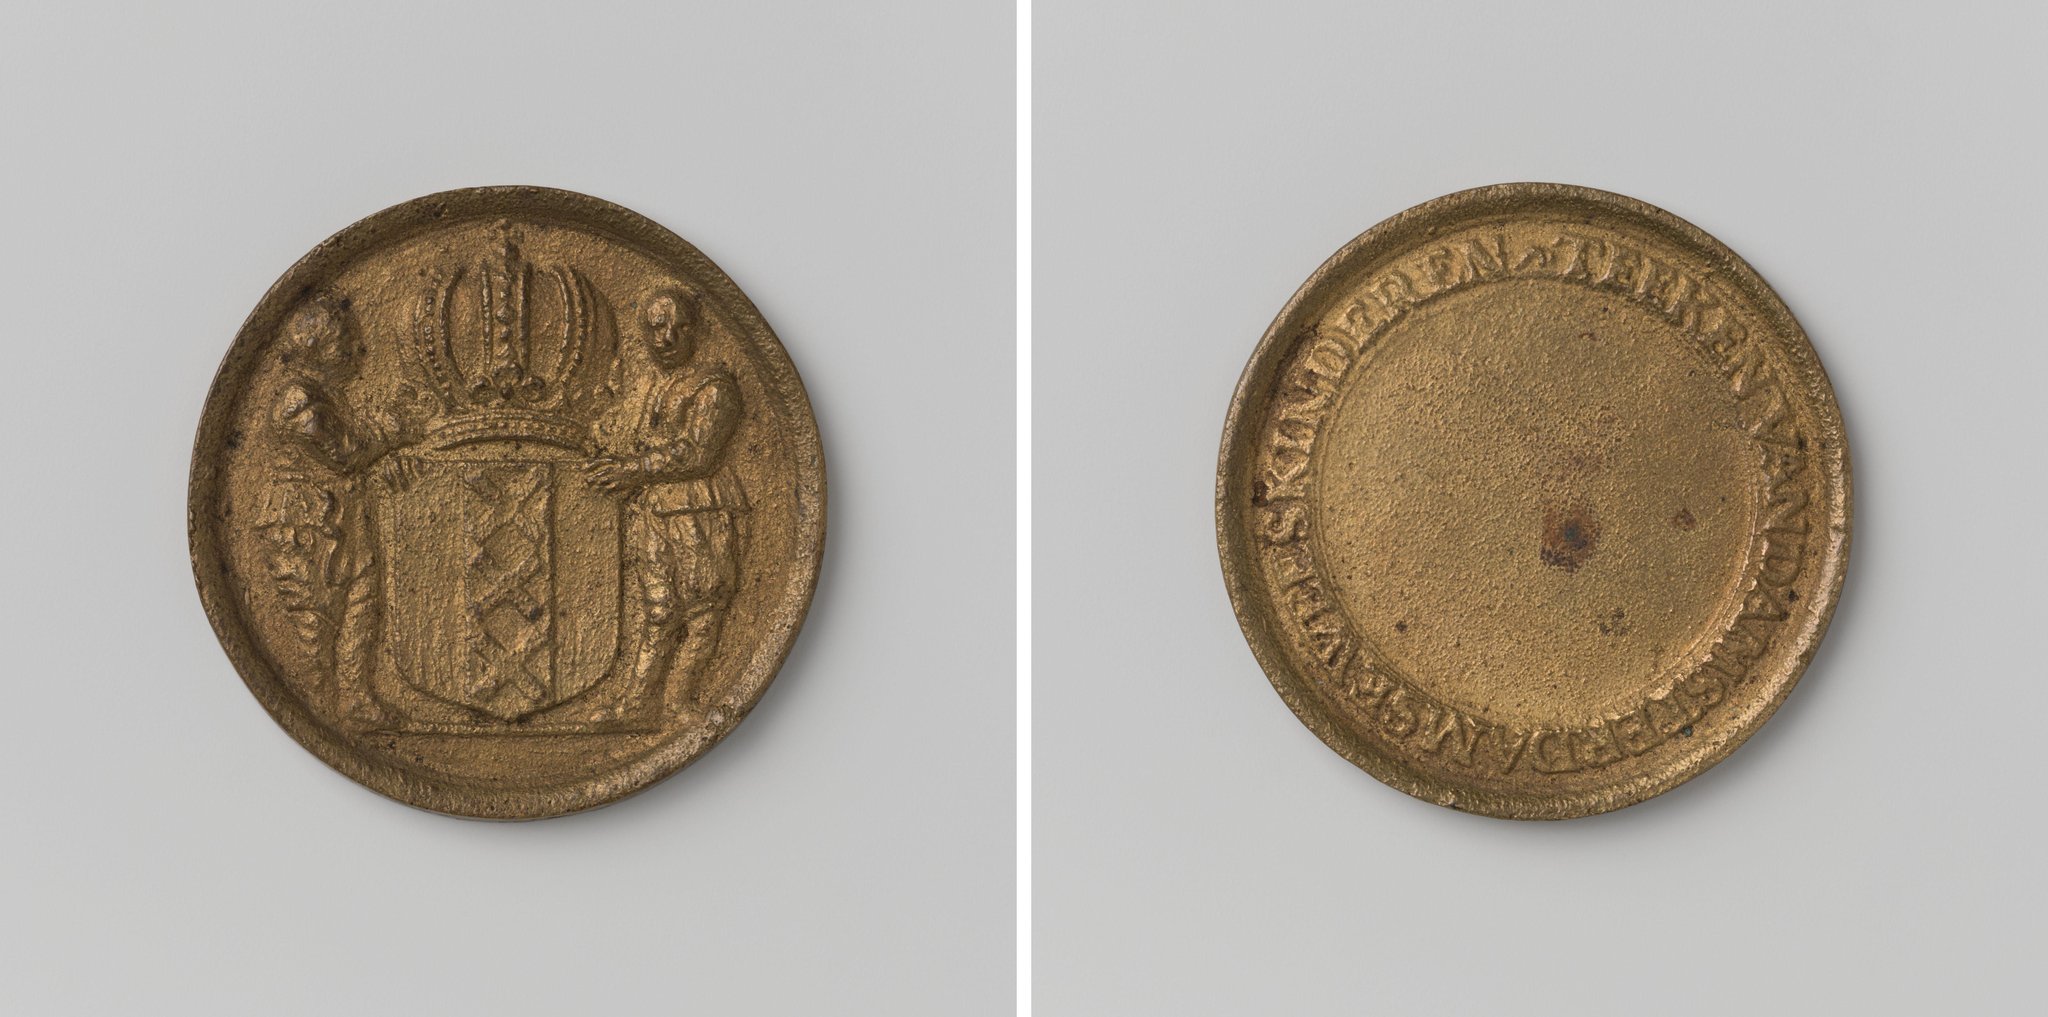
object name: identification medal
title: Burgerweeshuis te Amsterdam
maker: Anonymous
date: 1580-1800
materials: brass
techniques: casting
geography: amsterdam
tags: burgerweeshuis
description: Messing penning. Voorzijde: gekroond wapenschild, geflankeerd door twee weeskinderen. Keerzijde: leeg veld binnen omschrift